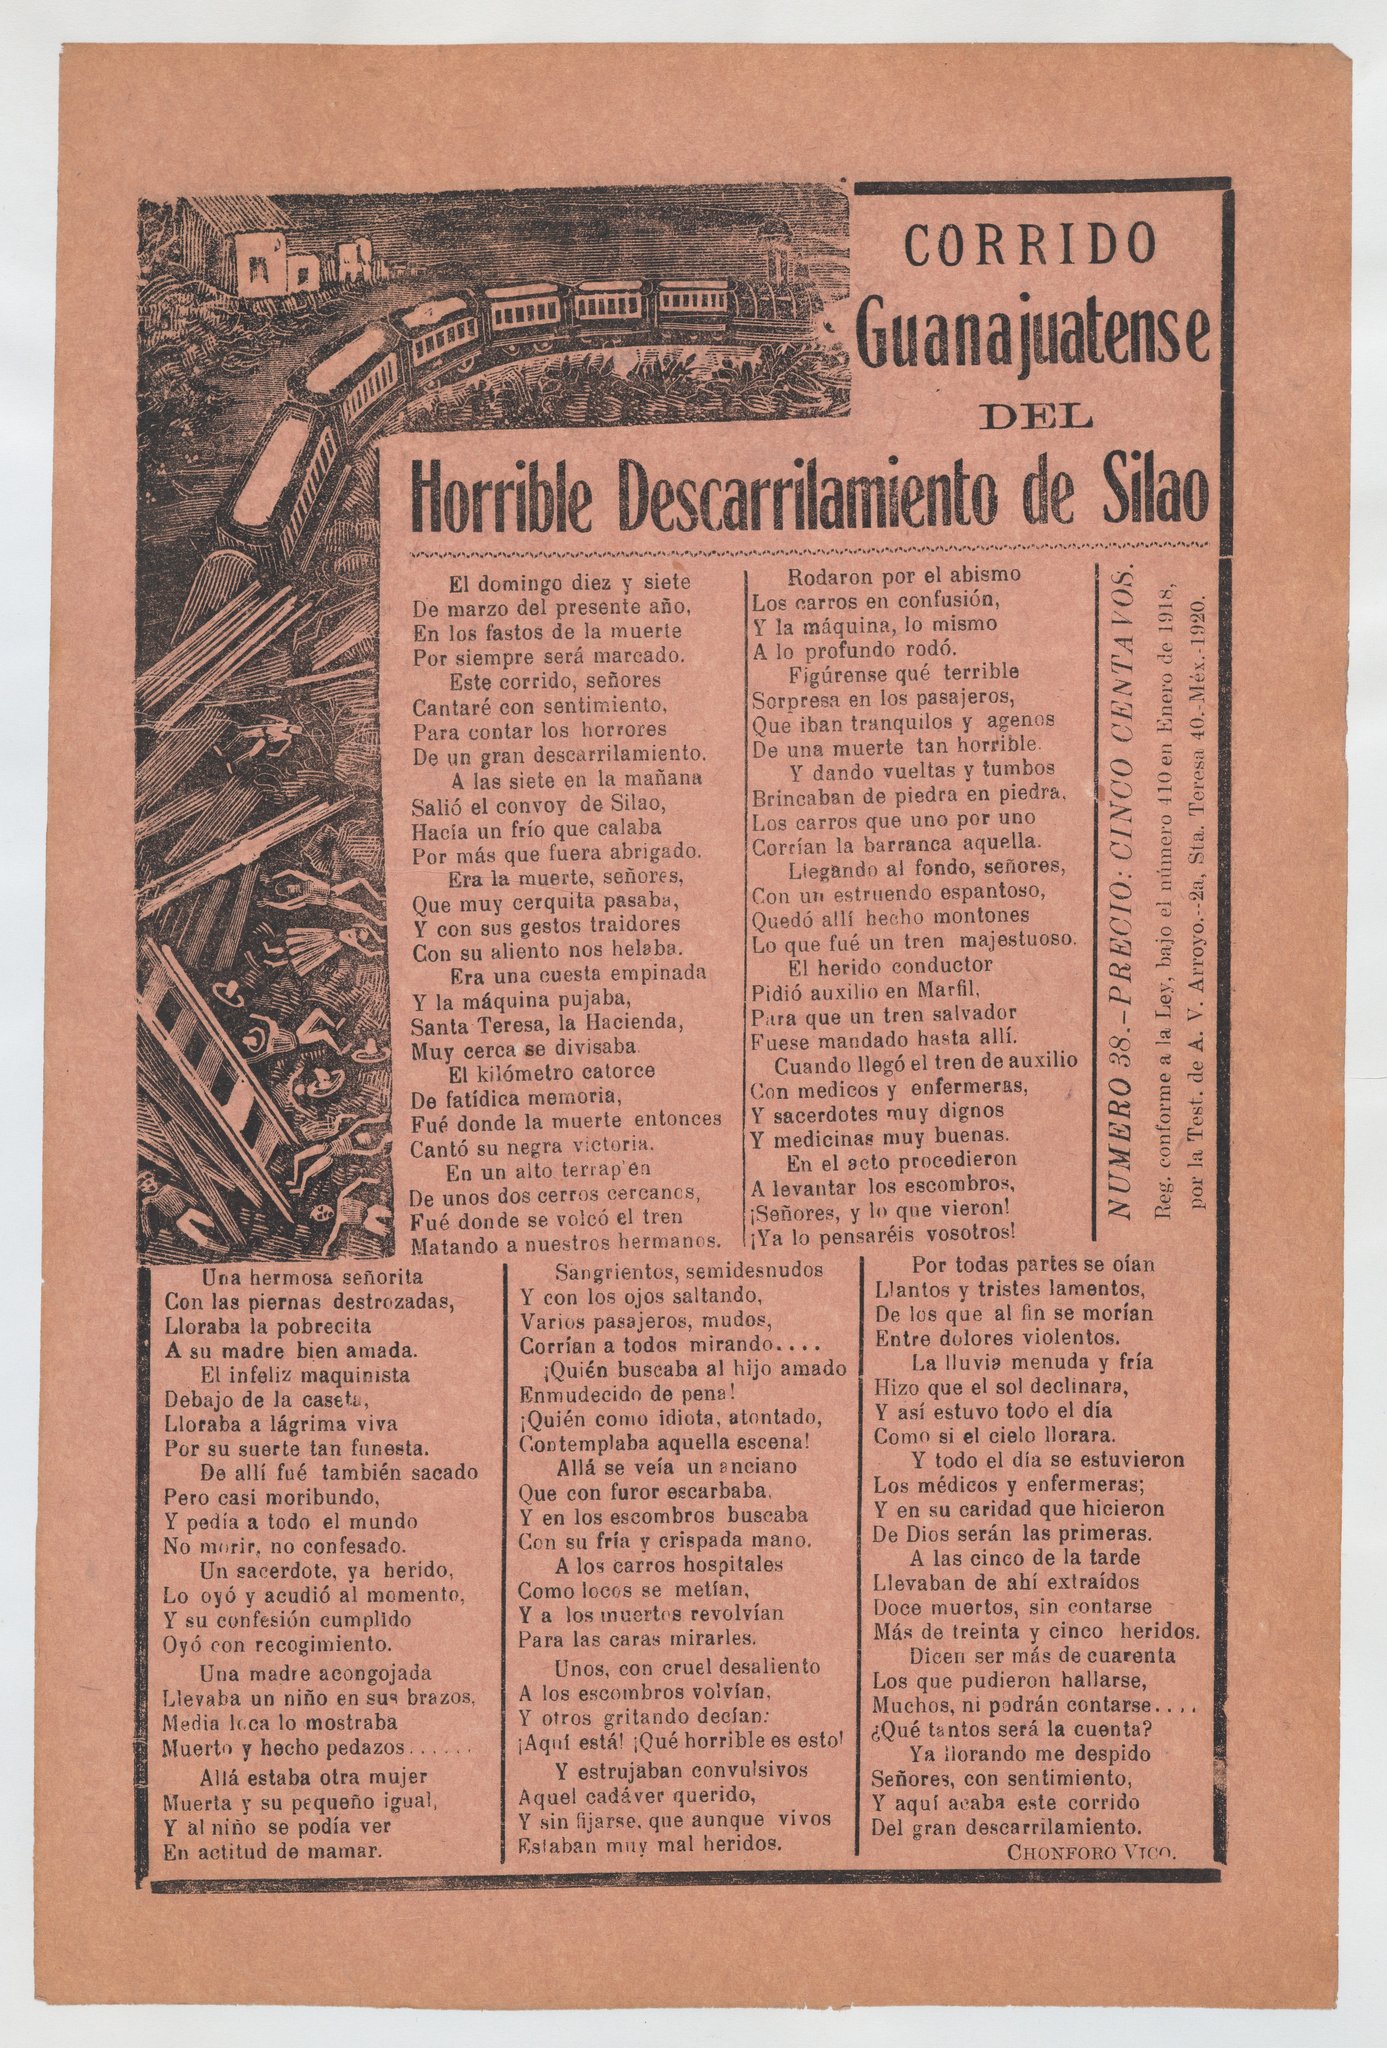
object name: print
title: Broadsheet relating to a train accident in Guanajuatense and the many fatalities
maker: josé guadalupe posada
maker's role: artist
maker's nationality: mexican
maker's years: 1852-1913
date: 1920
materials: metal, paper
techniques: engraving, letterpress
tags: trains,documents